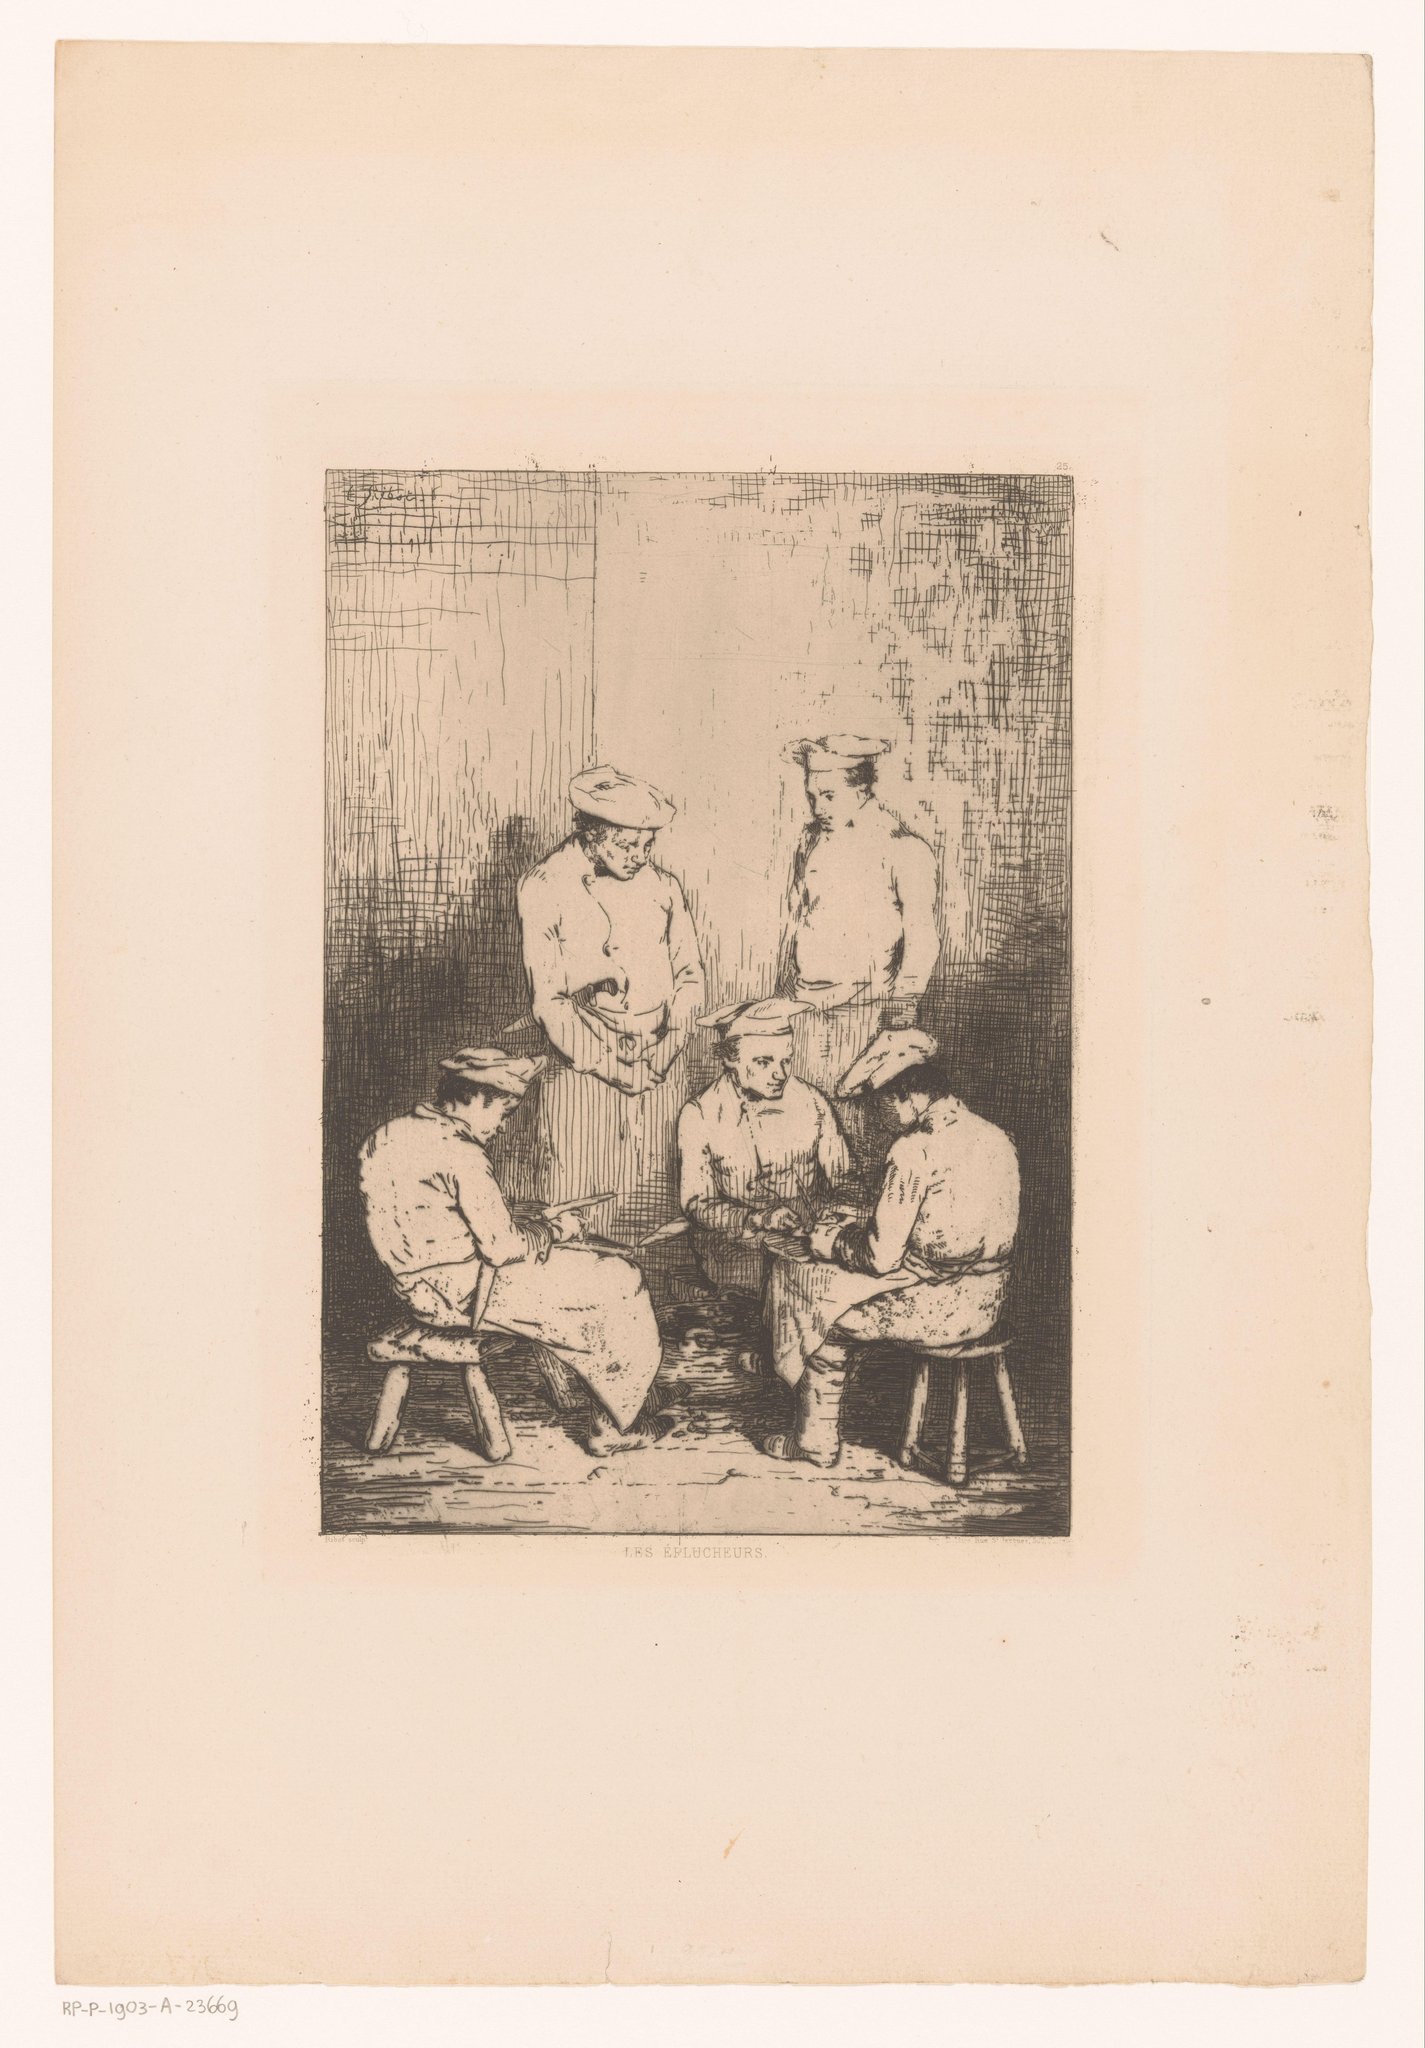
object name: print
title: Groep van vijf koks, waarvan er drie zitten te schillen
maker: théodule augustin ribot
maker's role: draughtsman, painter, print maker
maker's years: 1823-1891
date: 1862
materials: paper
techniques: drypoint, etching, intaglio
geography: paris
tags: cook, cleaning (food)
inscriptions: collector's mark: Lugt 2228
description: Maakt deel uit van het eerste volume van een serie prenten door de Société des Aquafortistes uit 1862. Plaat 25.